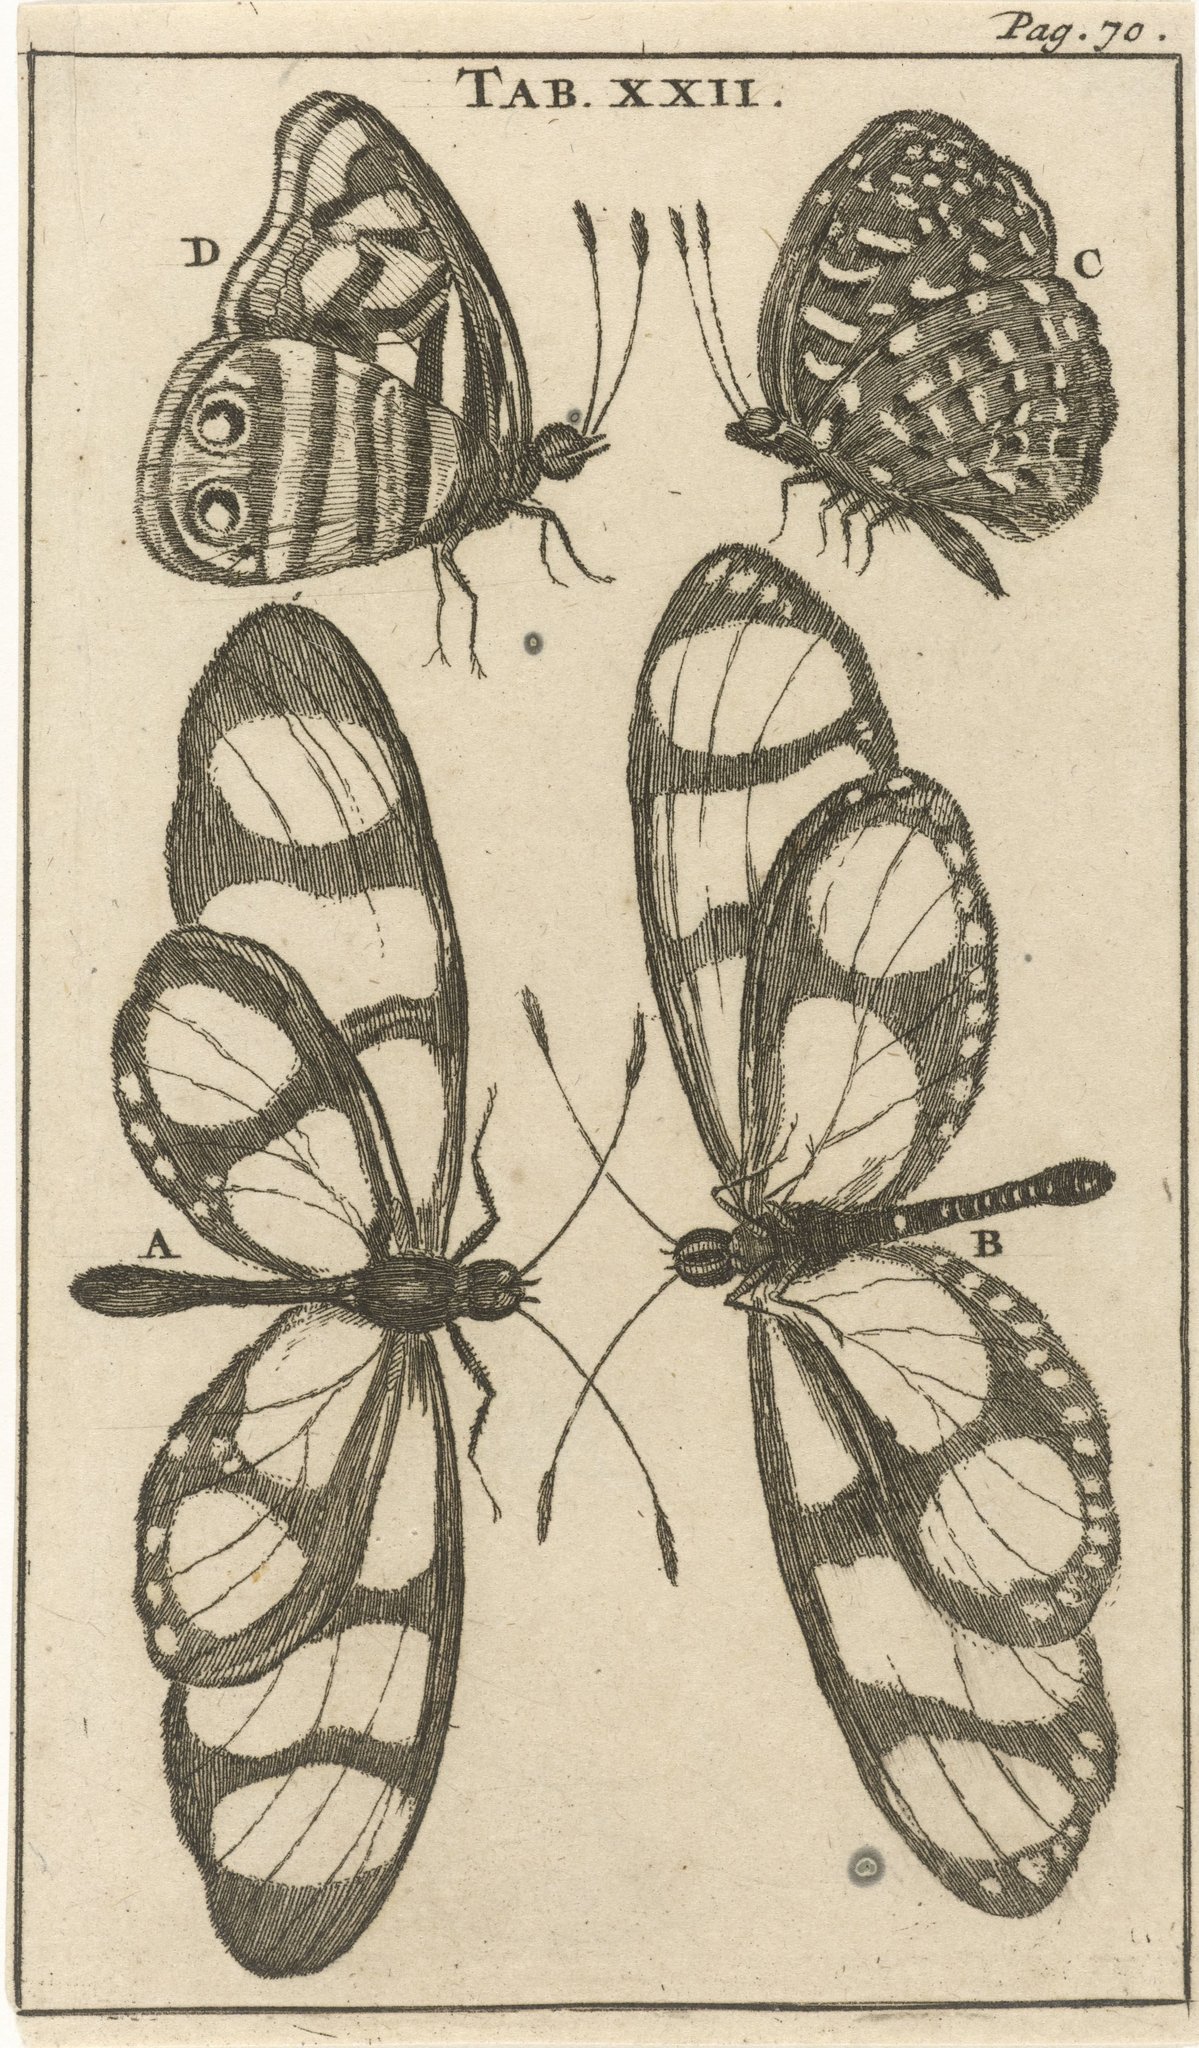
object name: print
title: Vlinders XXII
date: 1680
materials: paper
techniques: etching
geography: amsterdam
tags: insects: butterfly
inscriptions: collector's mark: Lugt 2228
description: Illustratie opgenomen in: Blankaart, Steven. Schou-burg der rupsen, wormen, ma'den, en vliegende dierkens daar uit voortkomende. Amsterdam: Jan Claesz ten Hoorn, 1680.